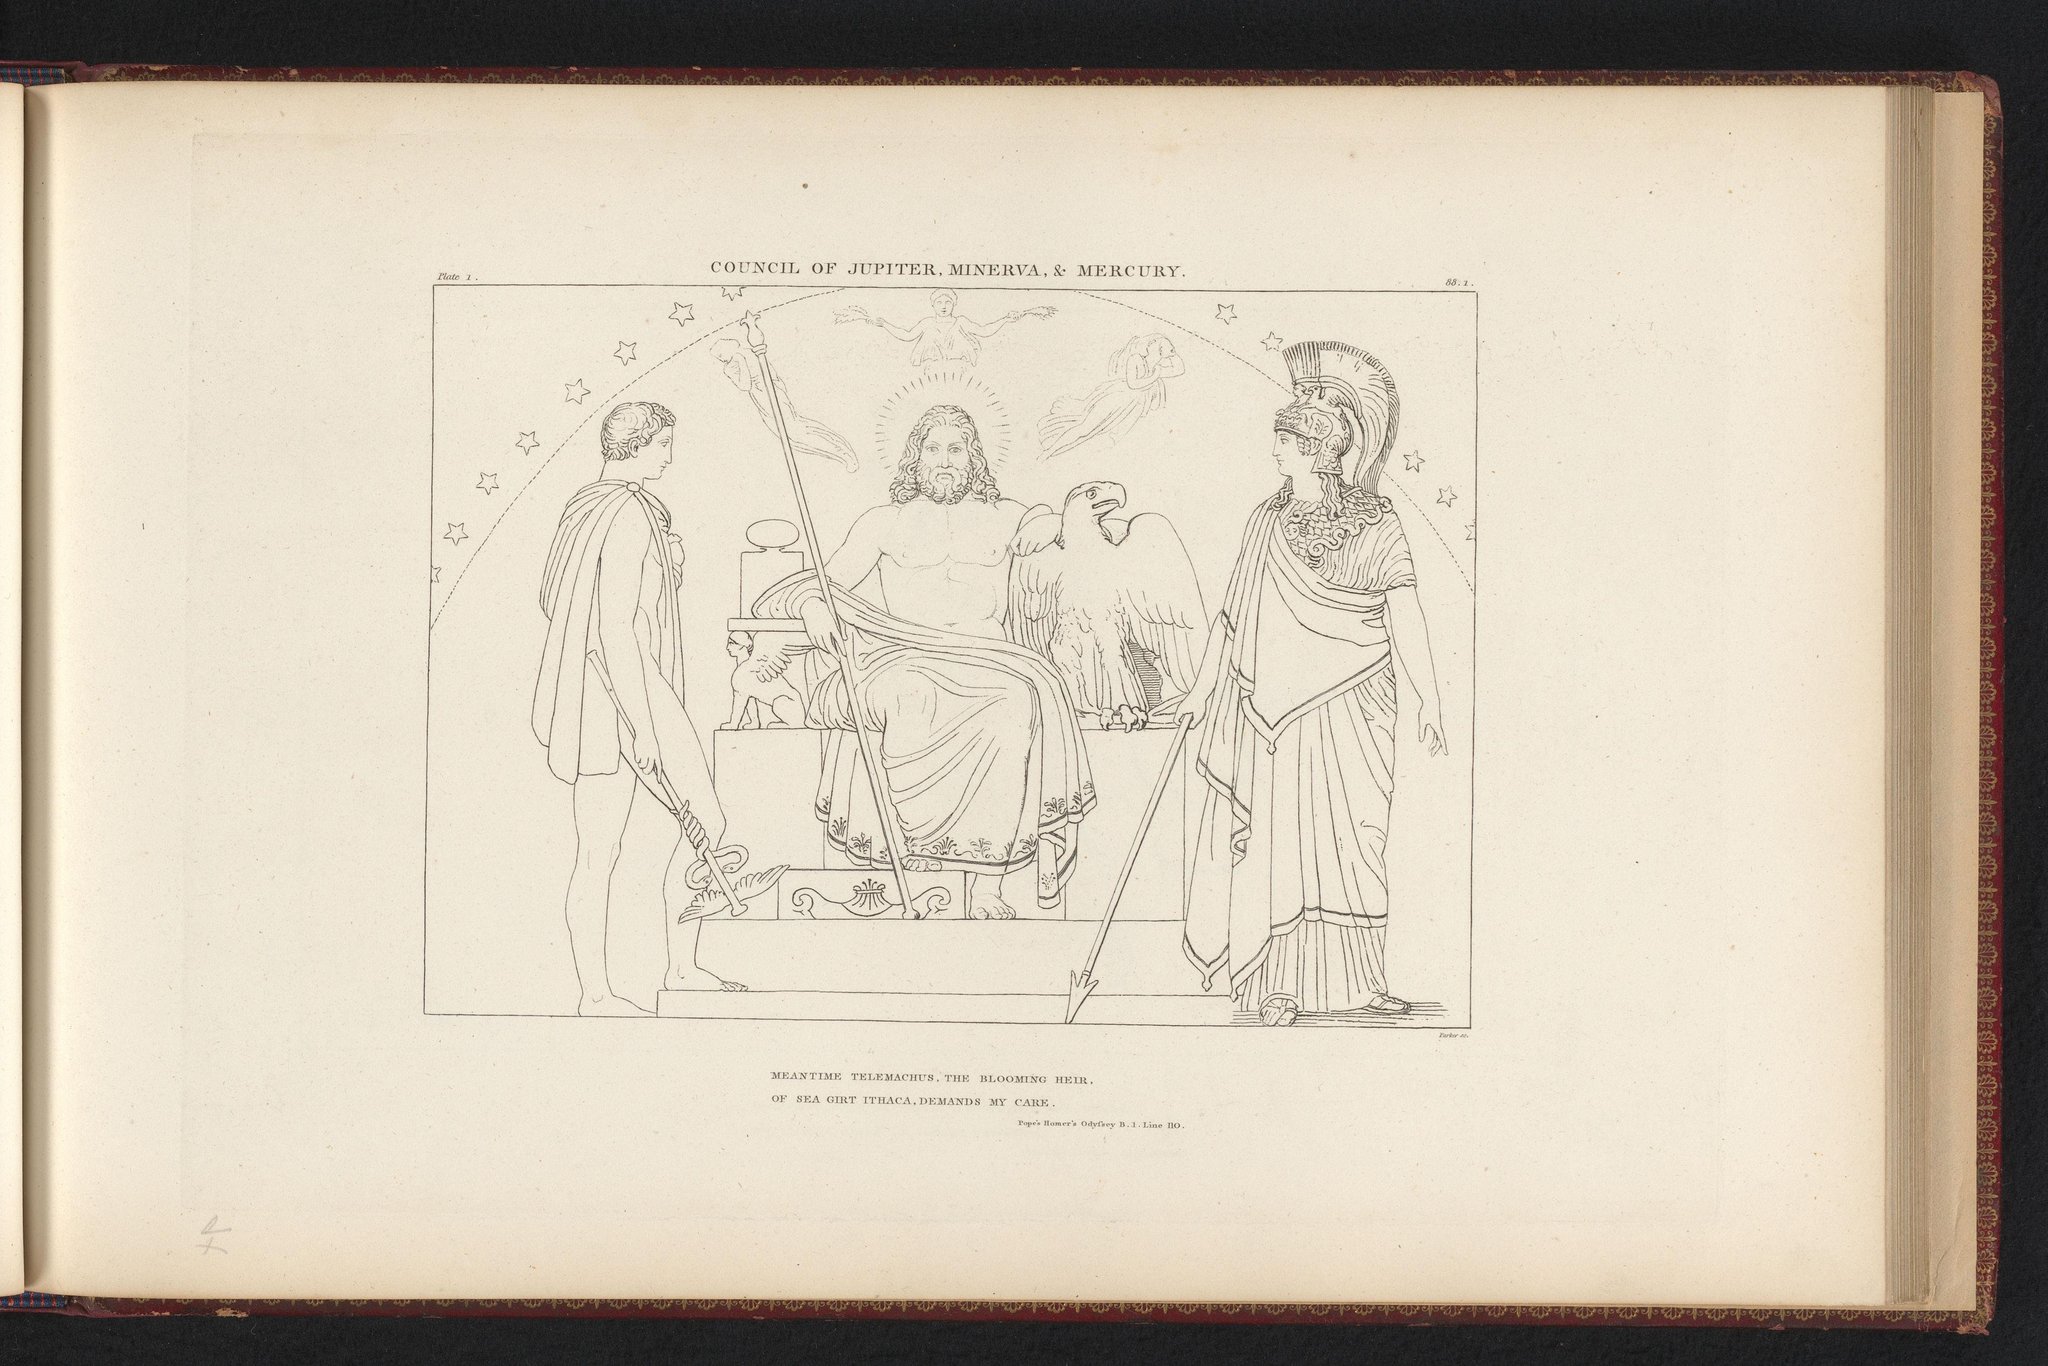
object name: album leaf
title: Odyssey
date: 1805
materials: paper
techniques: etching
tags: (story of) mercury (hermes), (story of) jupiter (zeus), specific aspects, allegorical aspects of minerva; minerva as patroness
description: Prent maakt onderdeel uit van een serie met 34 prenten over de Odyssee, geschreven door Homerus.